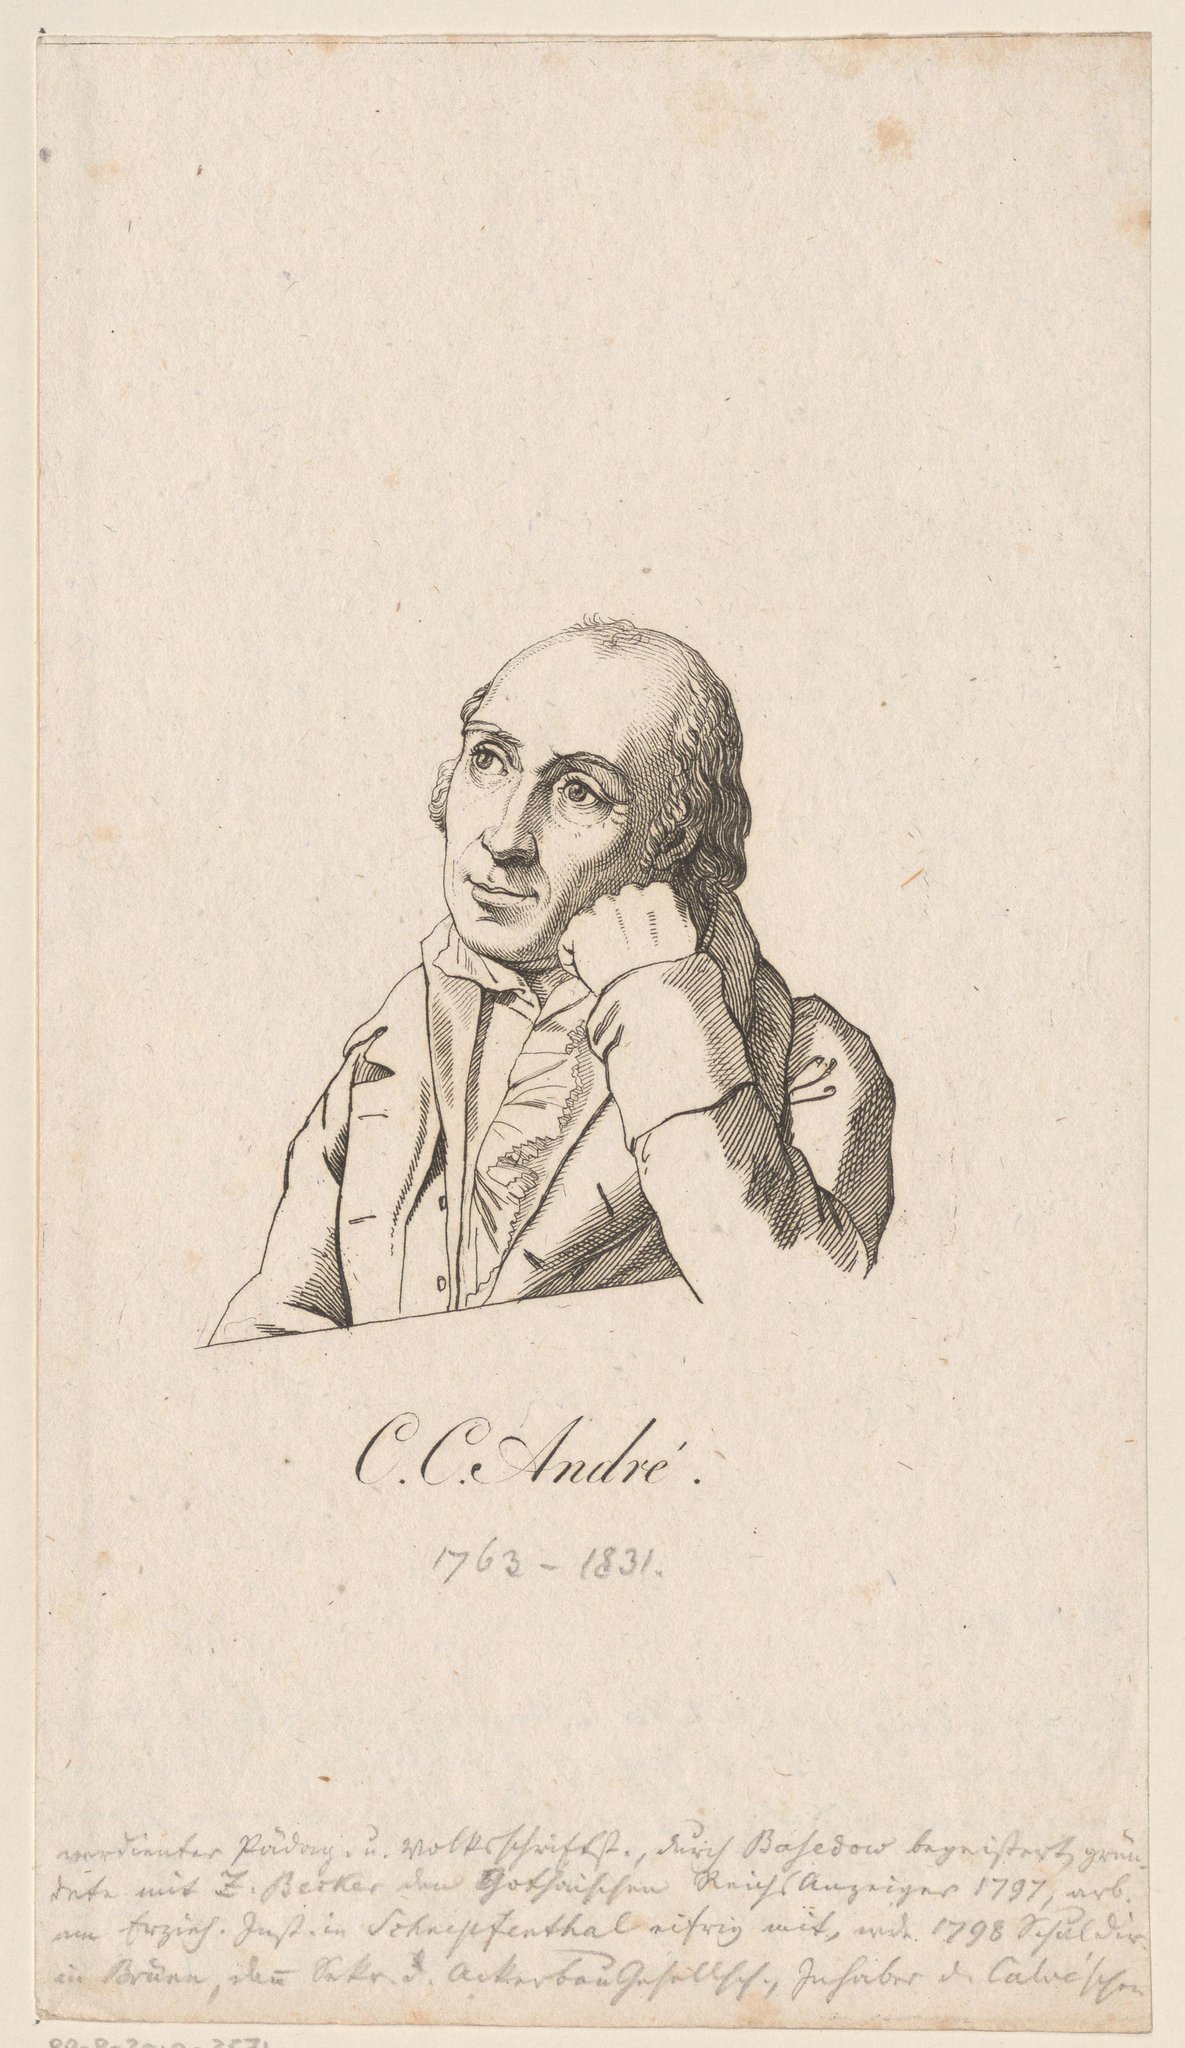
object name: print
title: Portret van Christian Carl André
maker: Anonymous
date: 1795-1850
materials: paper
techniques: etching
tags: historical persons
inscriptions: inscription: ‘[...]’